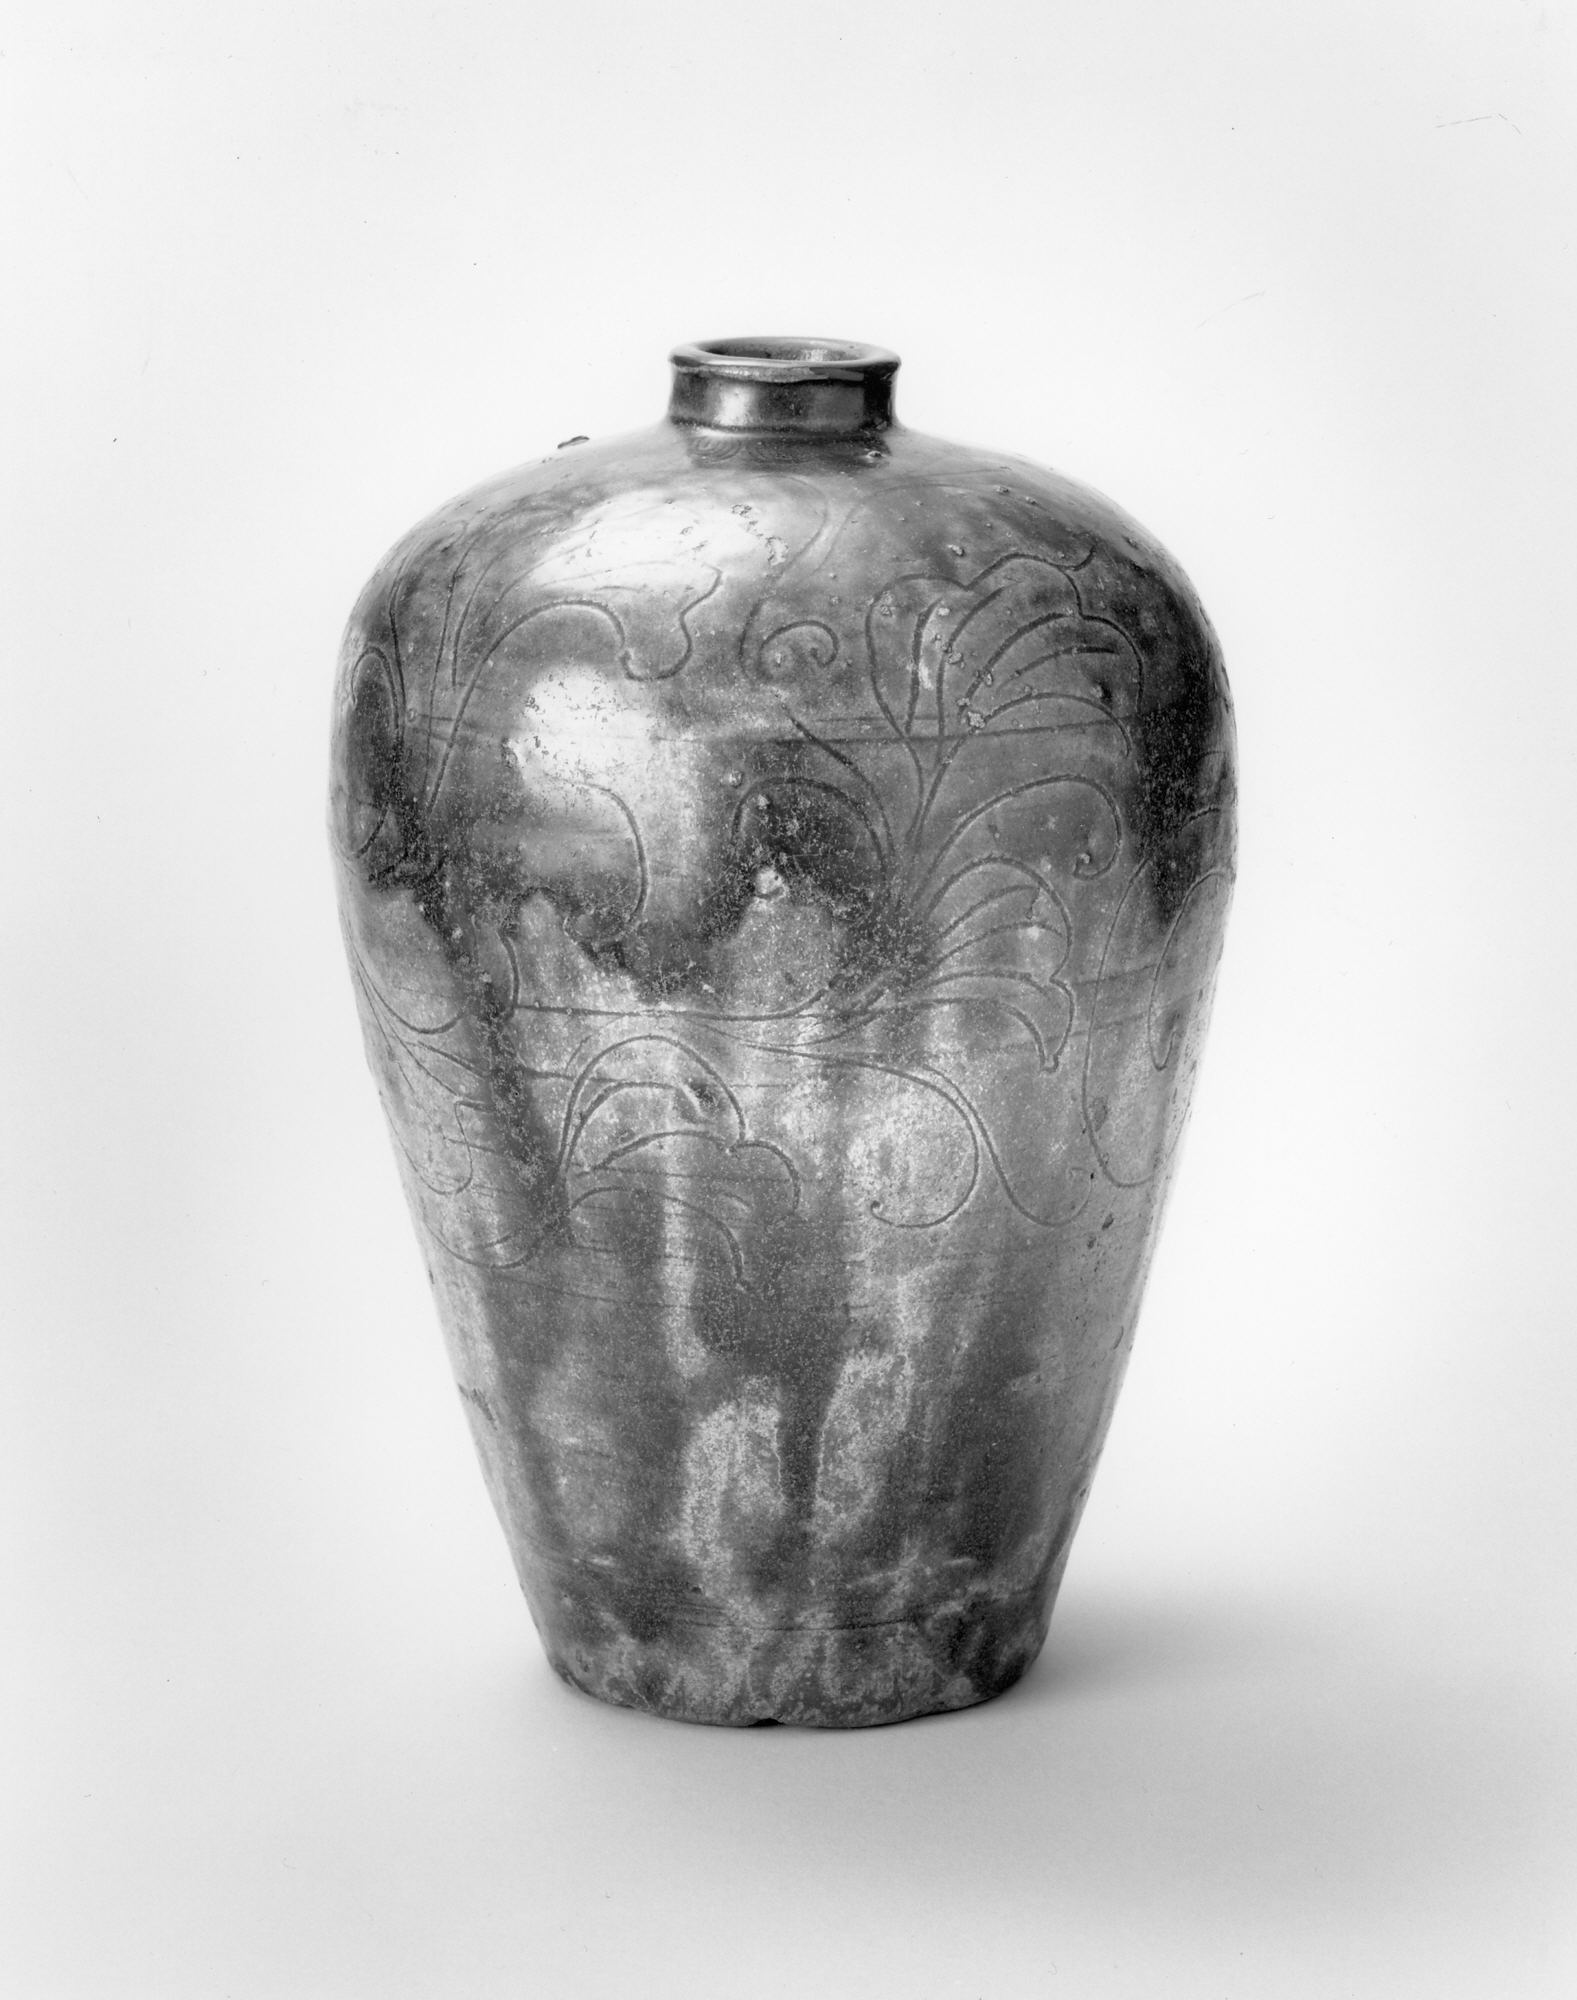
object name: jar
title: Jar in Meiping Shape with Incised Floral Design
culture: japanese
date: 1301-1400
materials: glaze, iron, stoneware